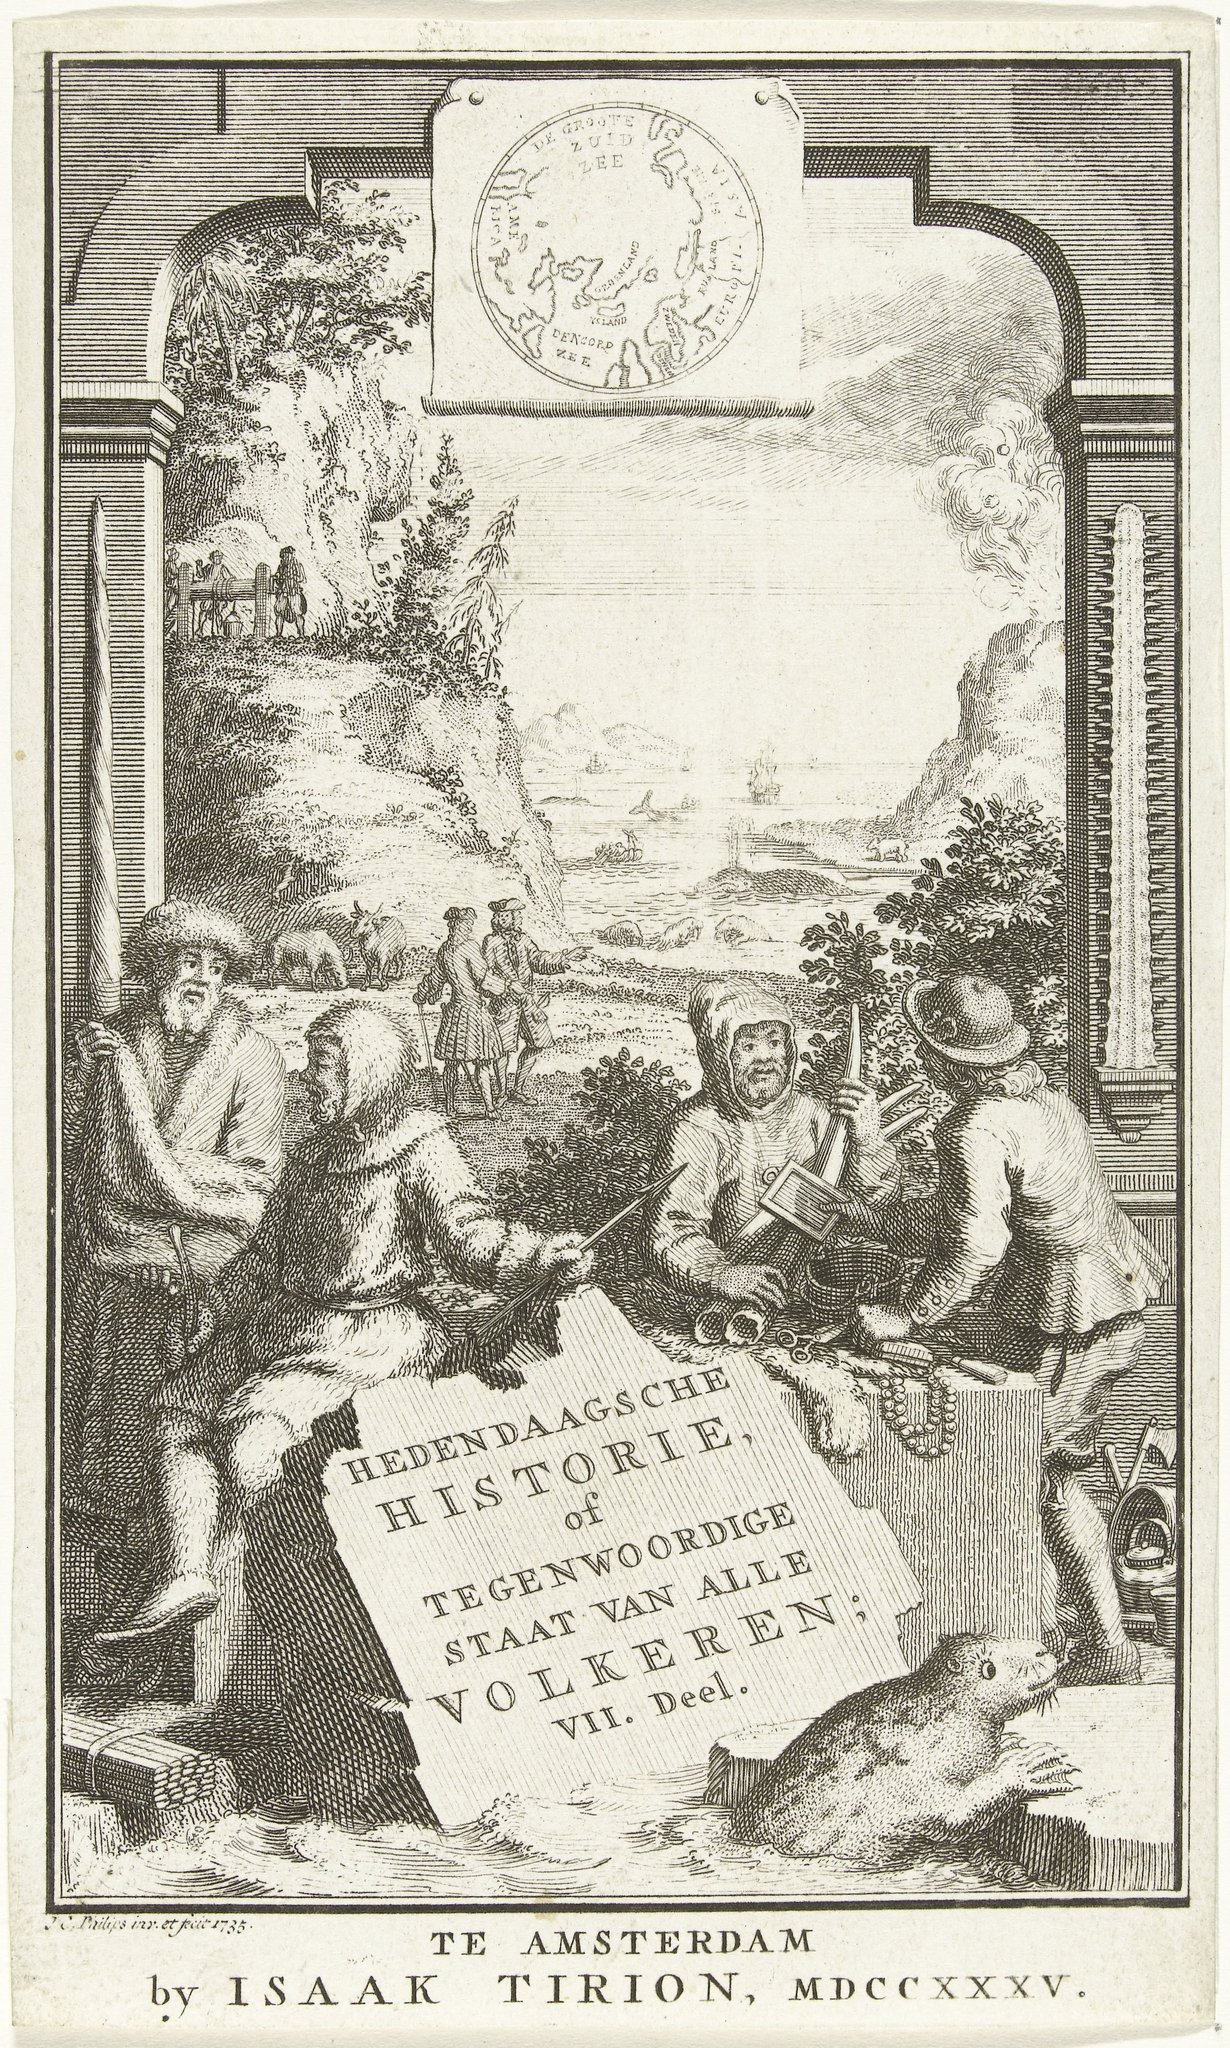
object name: titelblad, titelpagina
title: Titelpagina voor Hedendaagsche Historie, deel VII, 1735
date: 1735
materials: paper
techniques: etching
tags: indigenous peoples of the american arctic regions, indigenous peoples of central and east asia